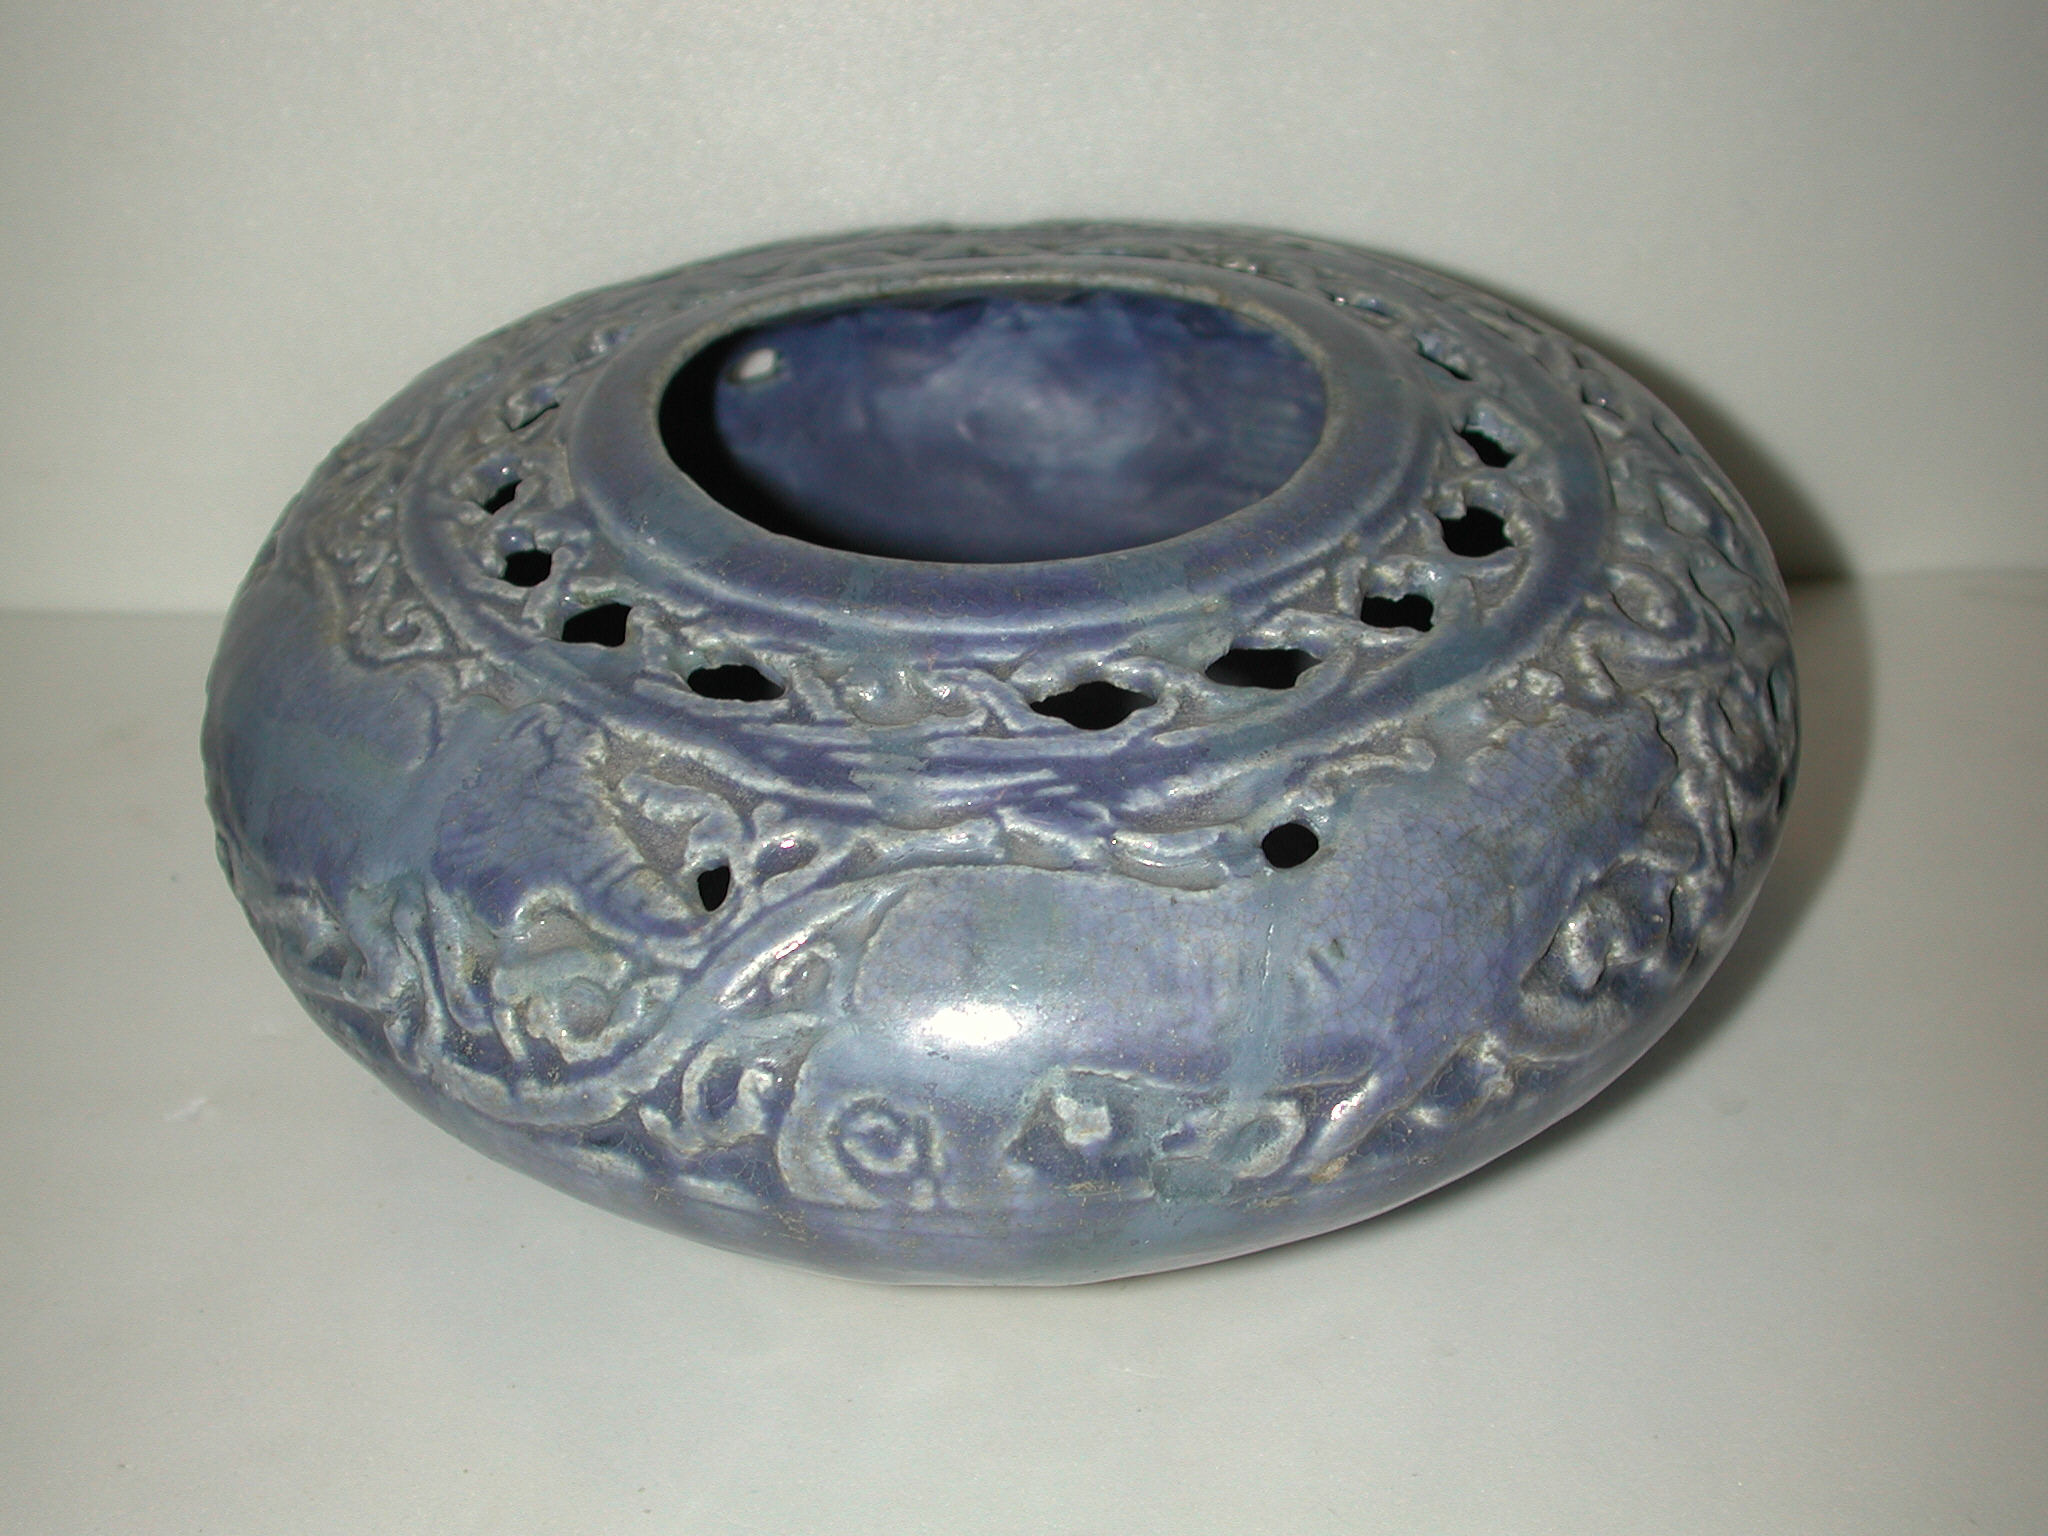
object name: vase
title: Pierced Blue Pot with Animals and Vegetal Scroll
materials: glaze, stonepaste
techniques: carving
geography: iran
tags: animals